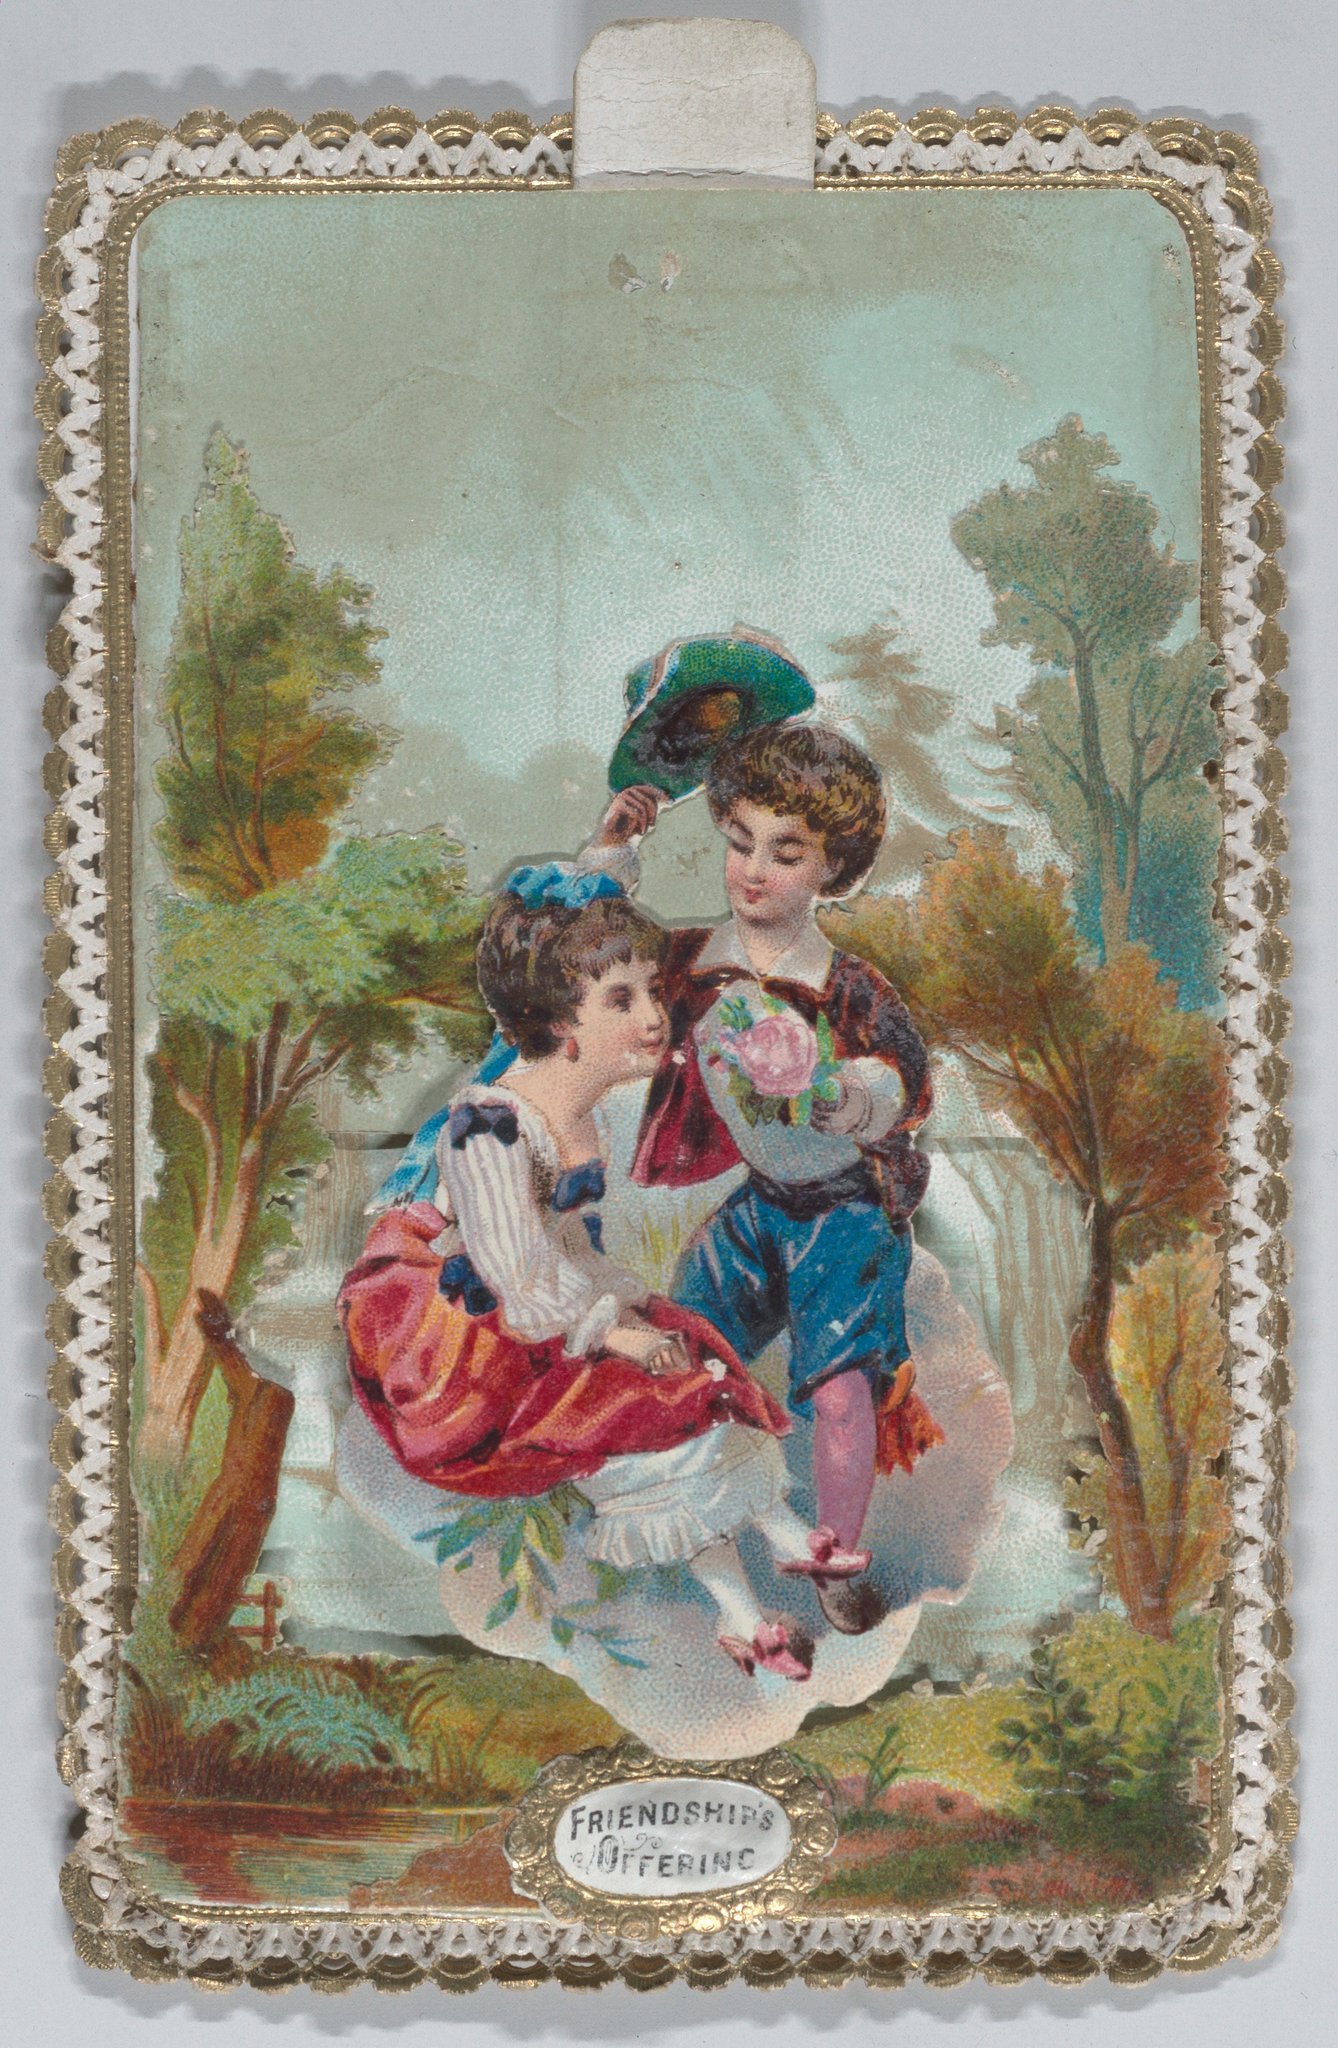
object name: valentine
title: Valentine - Mechanical scene, couple riding in a coach drawn by goats.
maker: Anonymous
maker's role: artist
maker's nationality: british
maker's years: 1800-1899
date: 1875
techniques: chromolithography, cutting, gilding